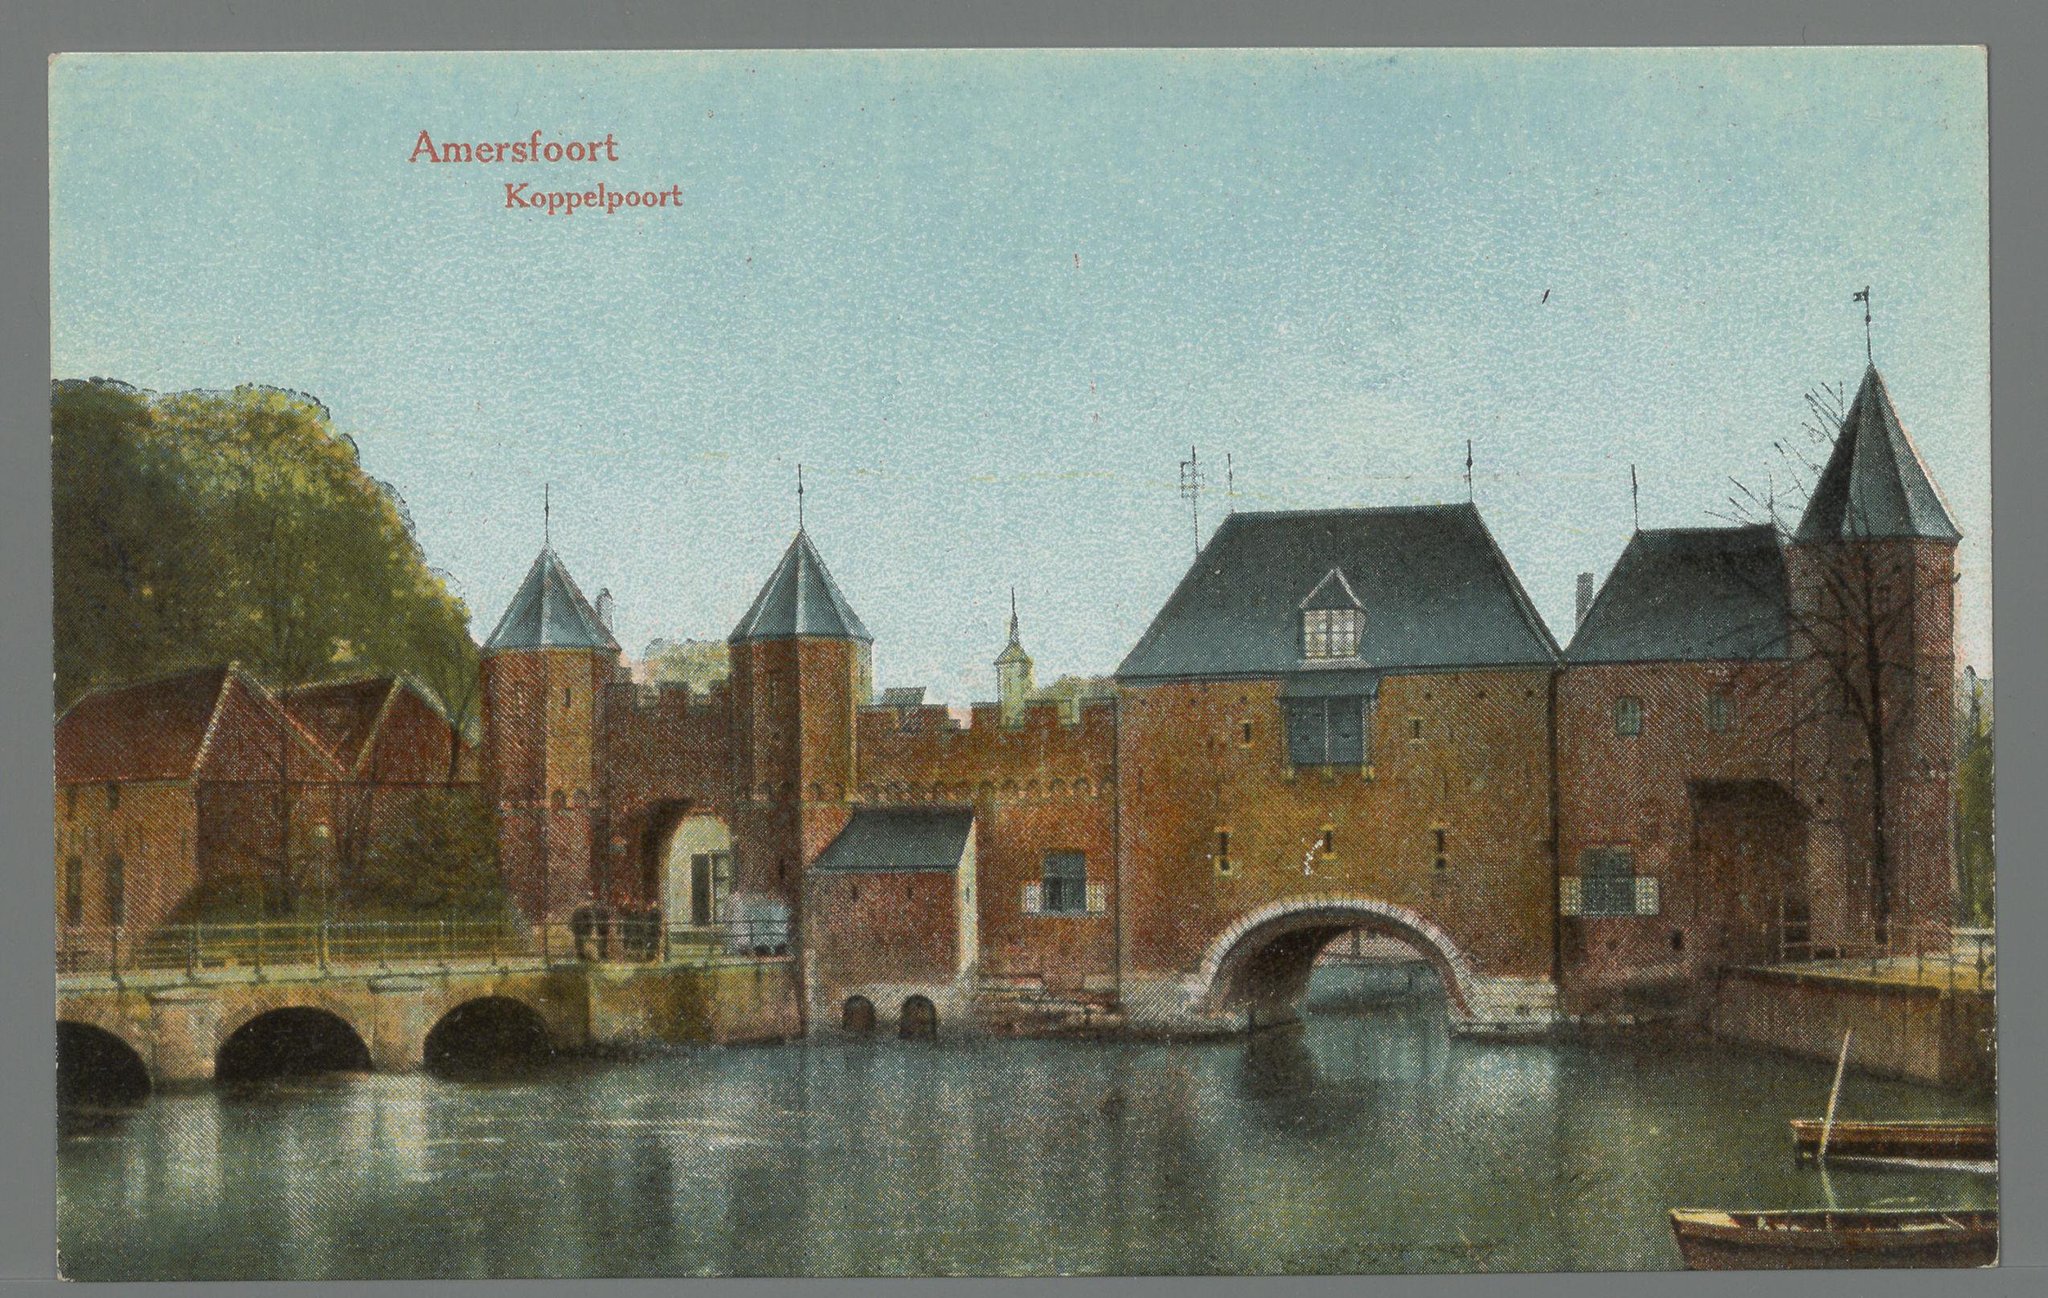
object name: ansichtkaart, prentbriefkaart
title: Amersfoort. Koppelpoort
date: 1905-1930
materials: cardboard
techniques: lithograph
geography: amersfoort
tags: watergate, canals, waters (in city), city-gate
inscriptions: monogram: ‘G.B.’